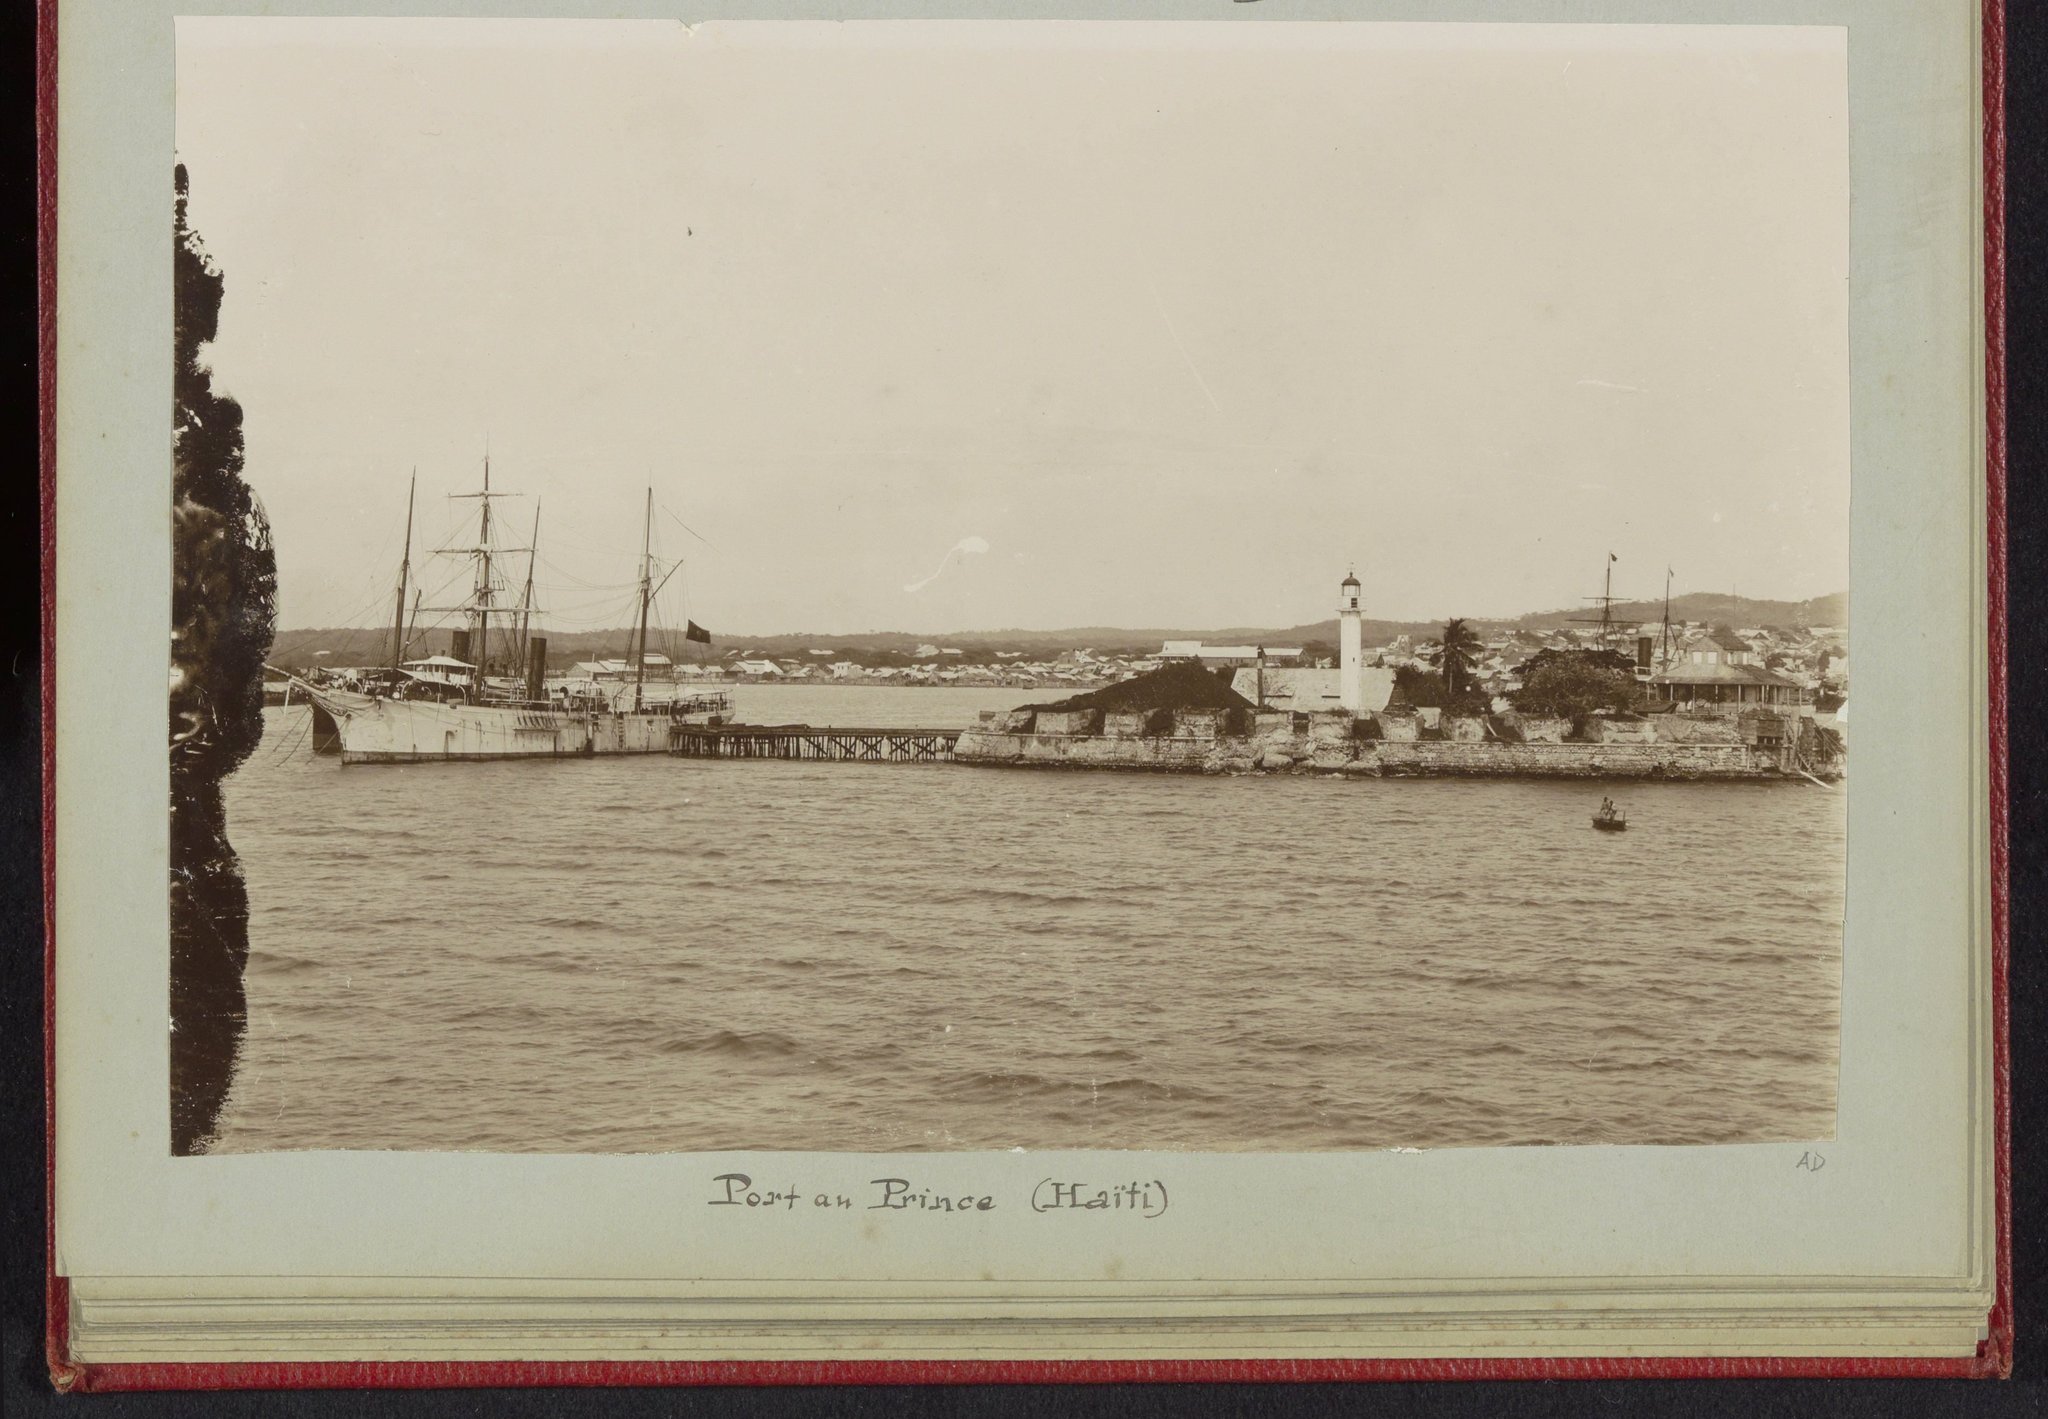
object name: photograph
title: Gezicht op de haven van Port-au-Prince op Haïti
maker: Anonymous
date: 1870-1900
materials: photographic support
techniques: collodion silver print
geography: port-au-prince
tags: harbour (+ view ~ vehicle, ship, etc.)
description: Onderdeel van Fotoalbum met opnames van bezienswaardigheden in Europa, Trinidad, Haïti, Martinique en Suriname.